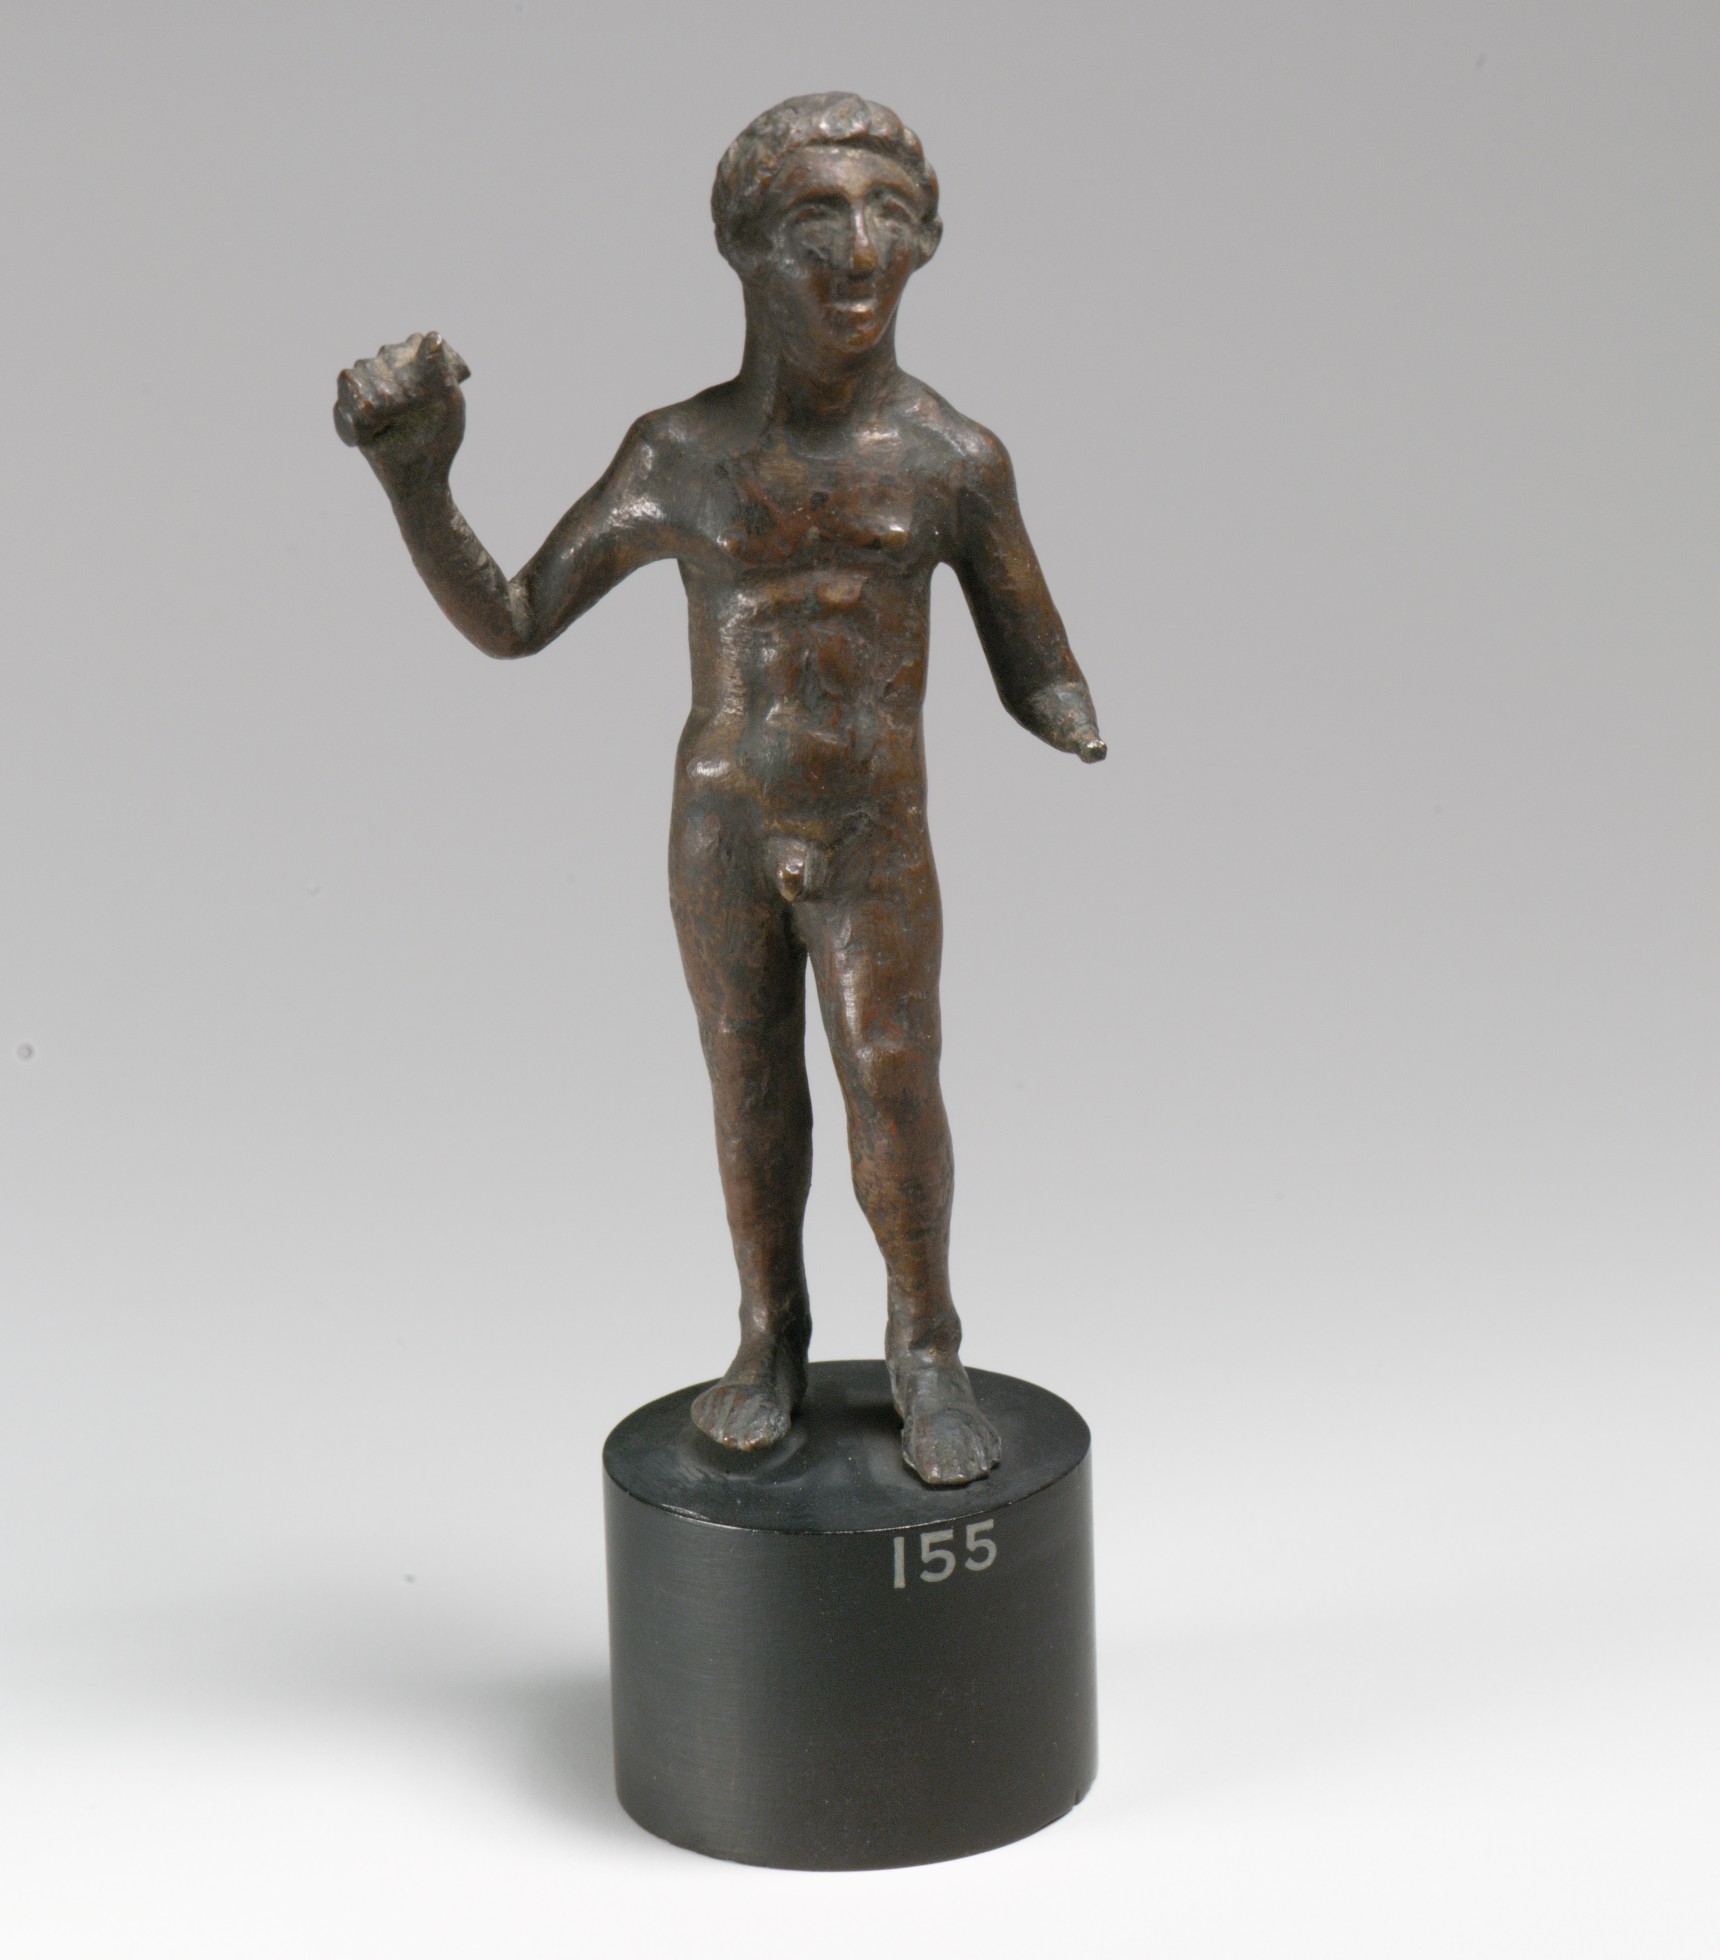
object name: statuette of herakles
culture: etruscan or roman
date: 300 BCE-200 CE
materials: bronze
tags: herakles